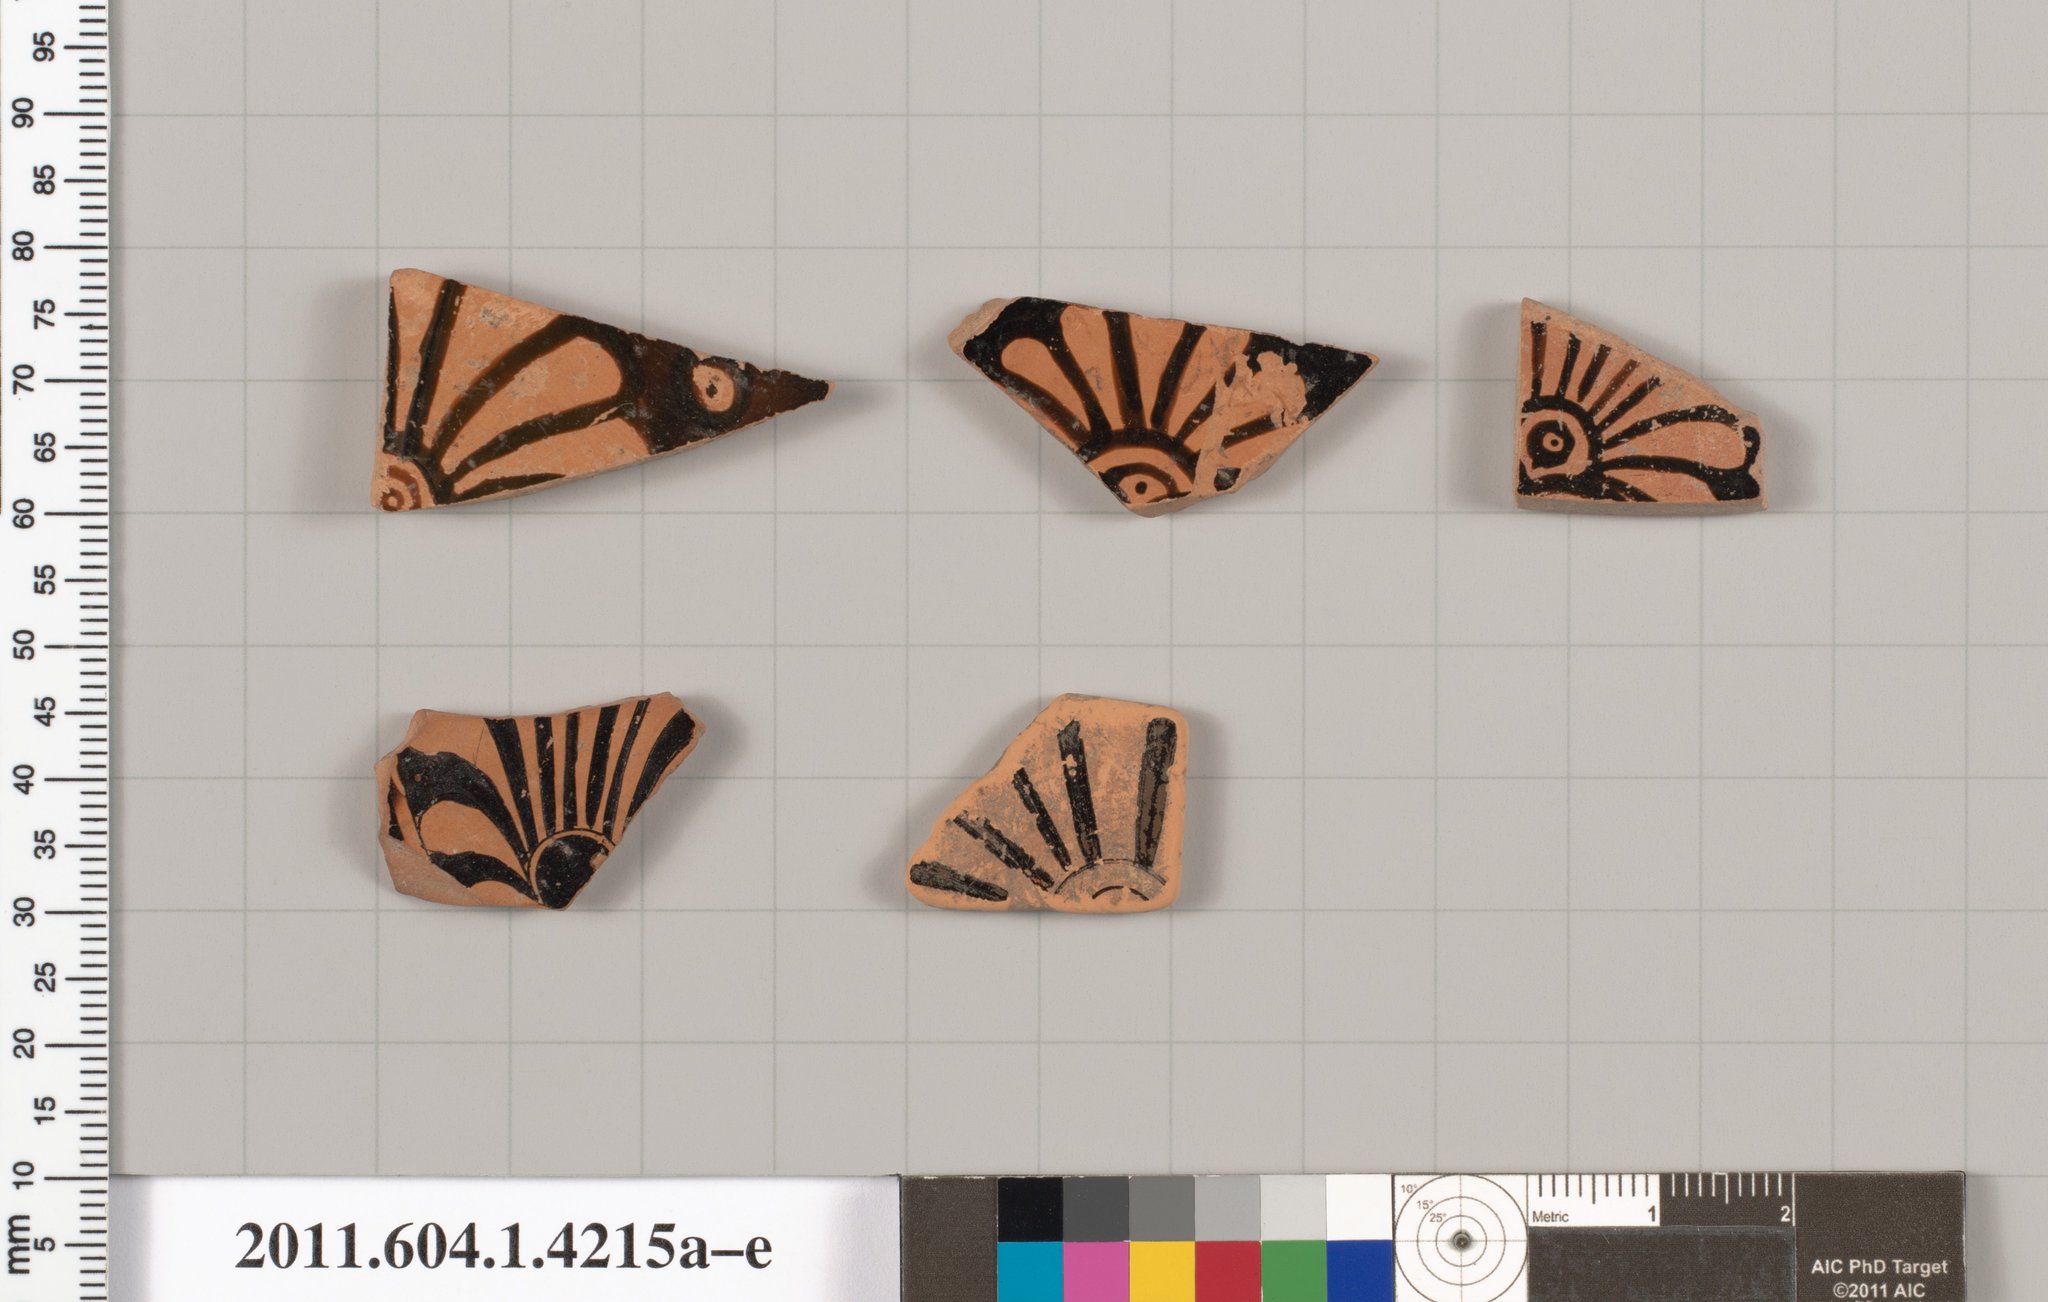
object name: kylix fragment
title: Terracotta fragments of kylikes (drinking cups)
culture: greek, attic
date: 500-451 BCE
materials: terracotta